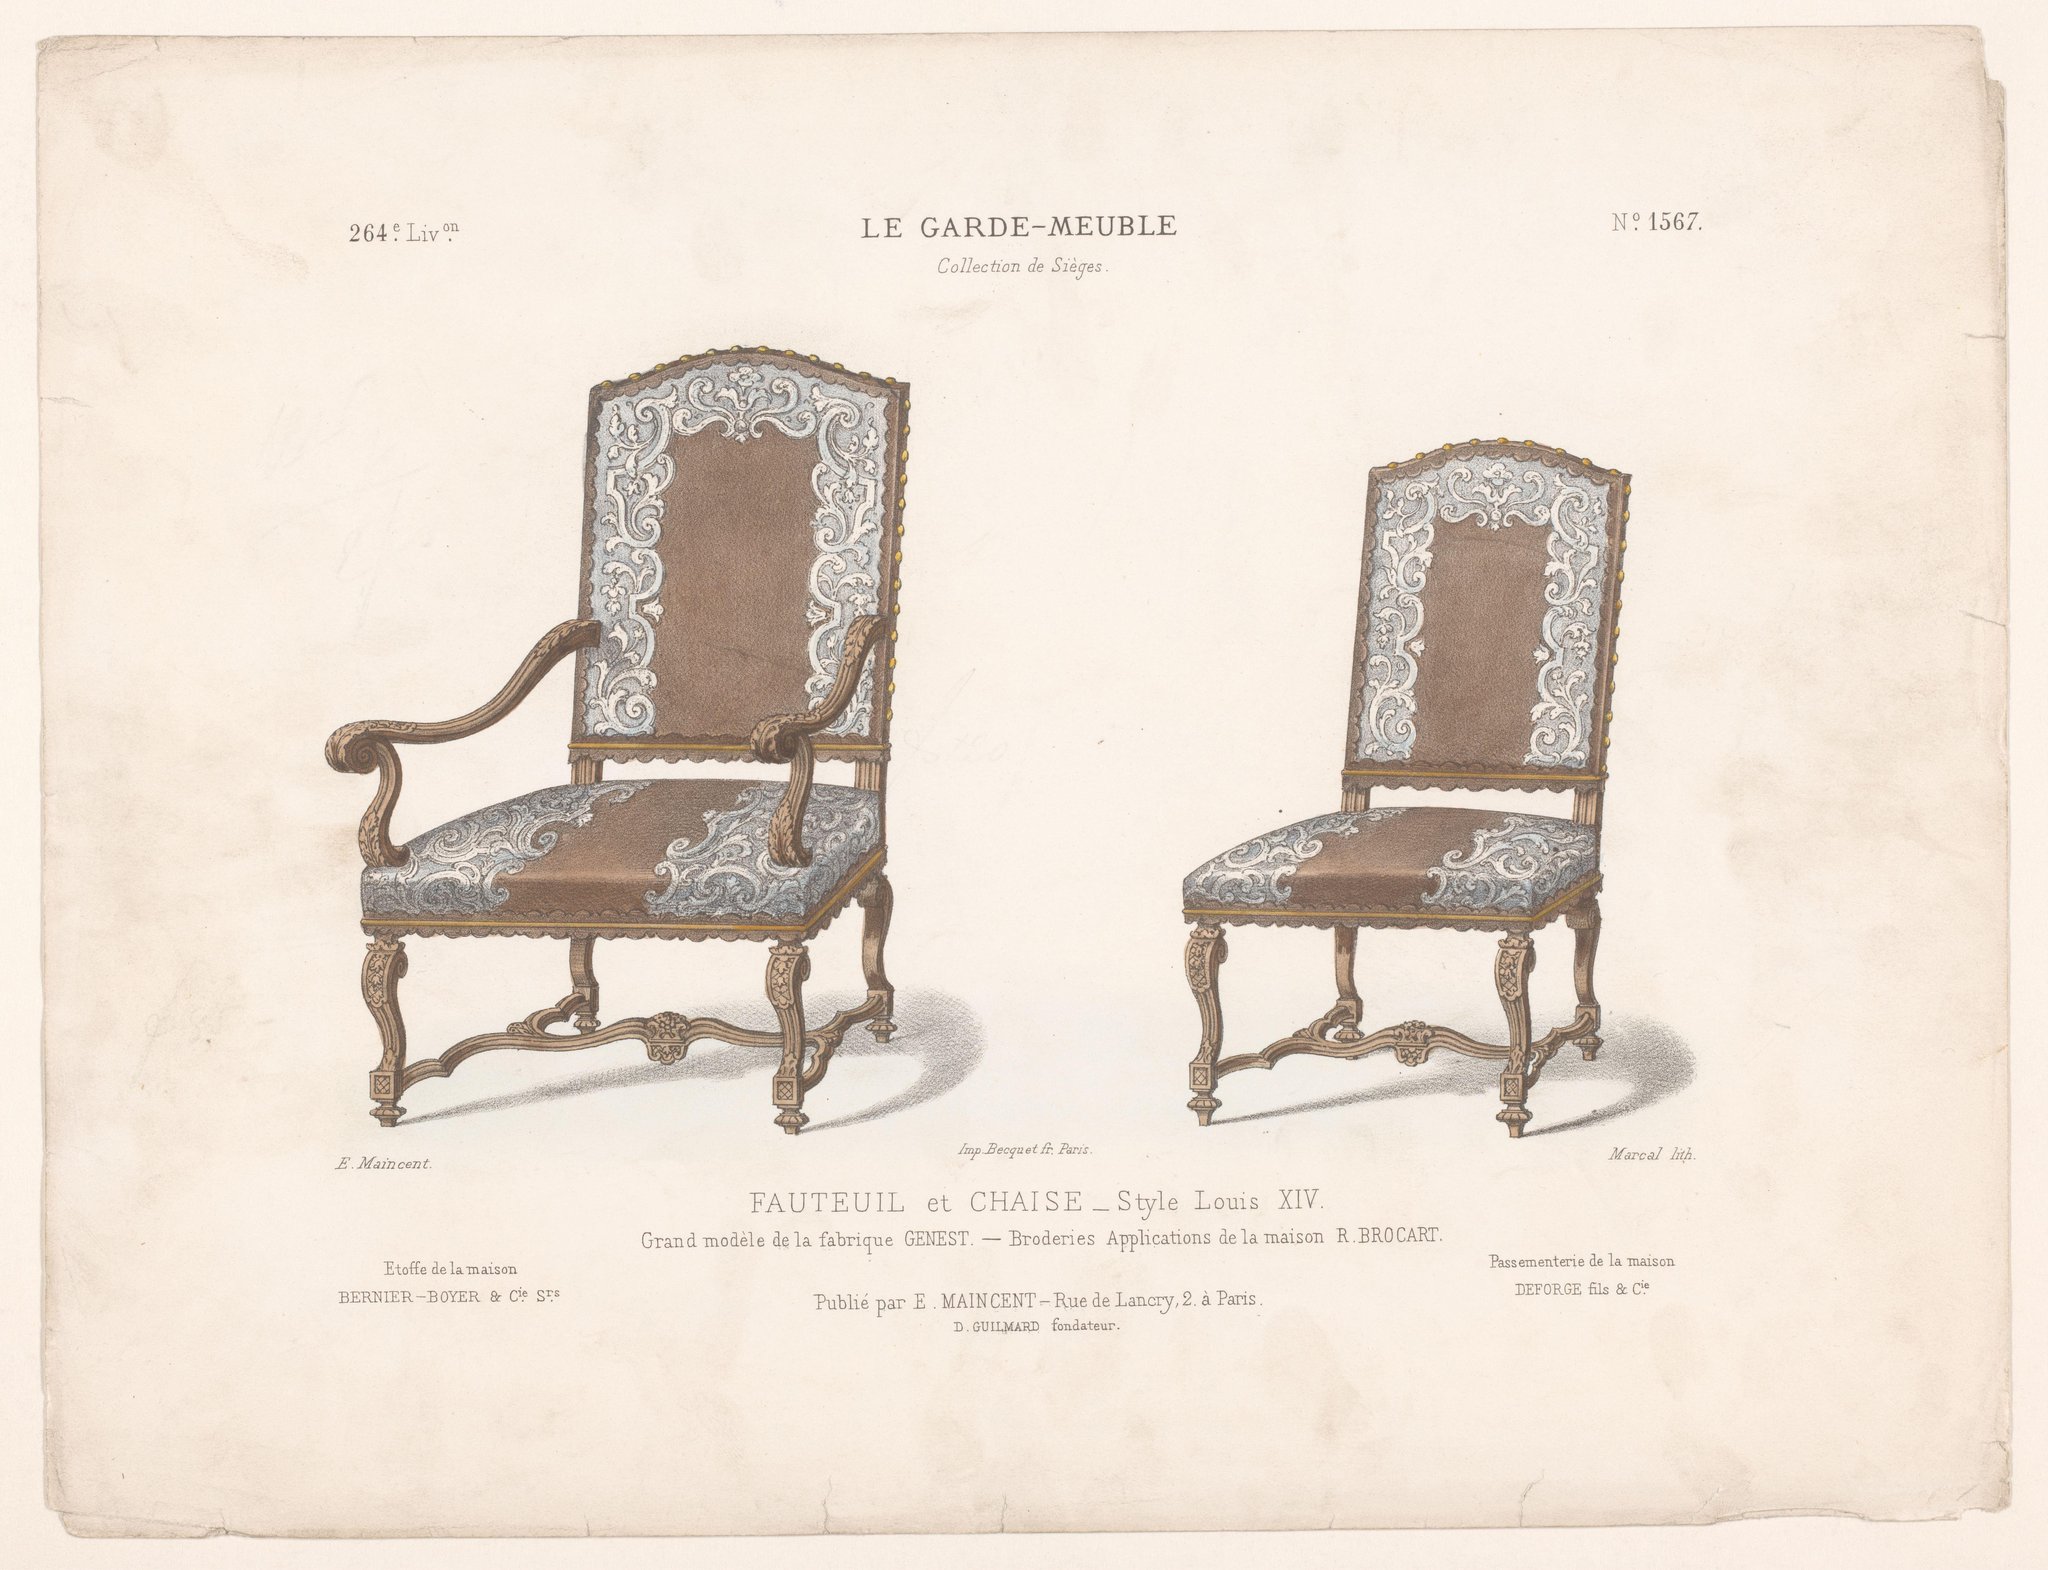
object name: print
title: Fauteuil et chaise Style Louis XIV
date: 1885-1895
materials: paper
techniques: hand coloring, lithograph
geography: paris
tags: seating furniture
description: Ieder Livraison in de serie Le Garde-Meuble bevat negen platen: drie 'sièges' (zitmeubels), drie 'meubles' (diverse meubels zoals tafels en kasten) en drie 'tentures' (gordijnen en draperieën).